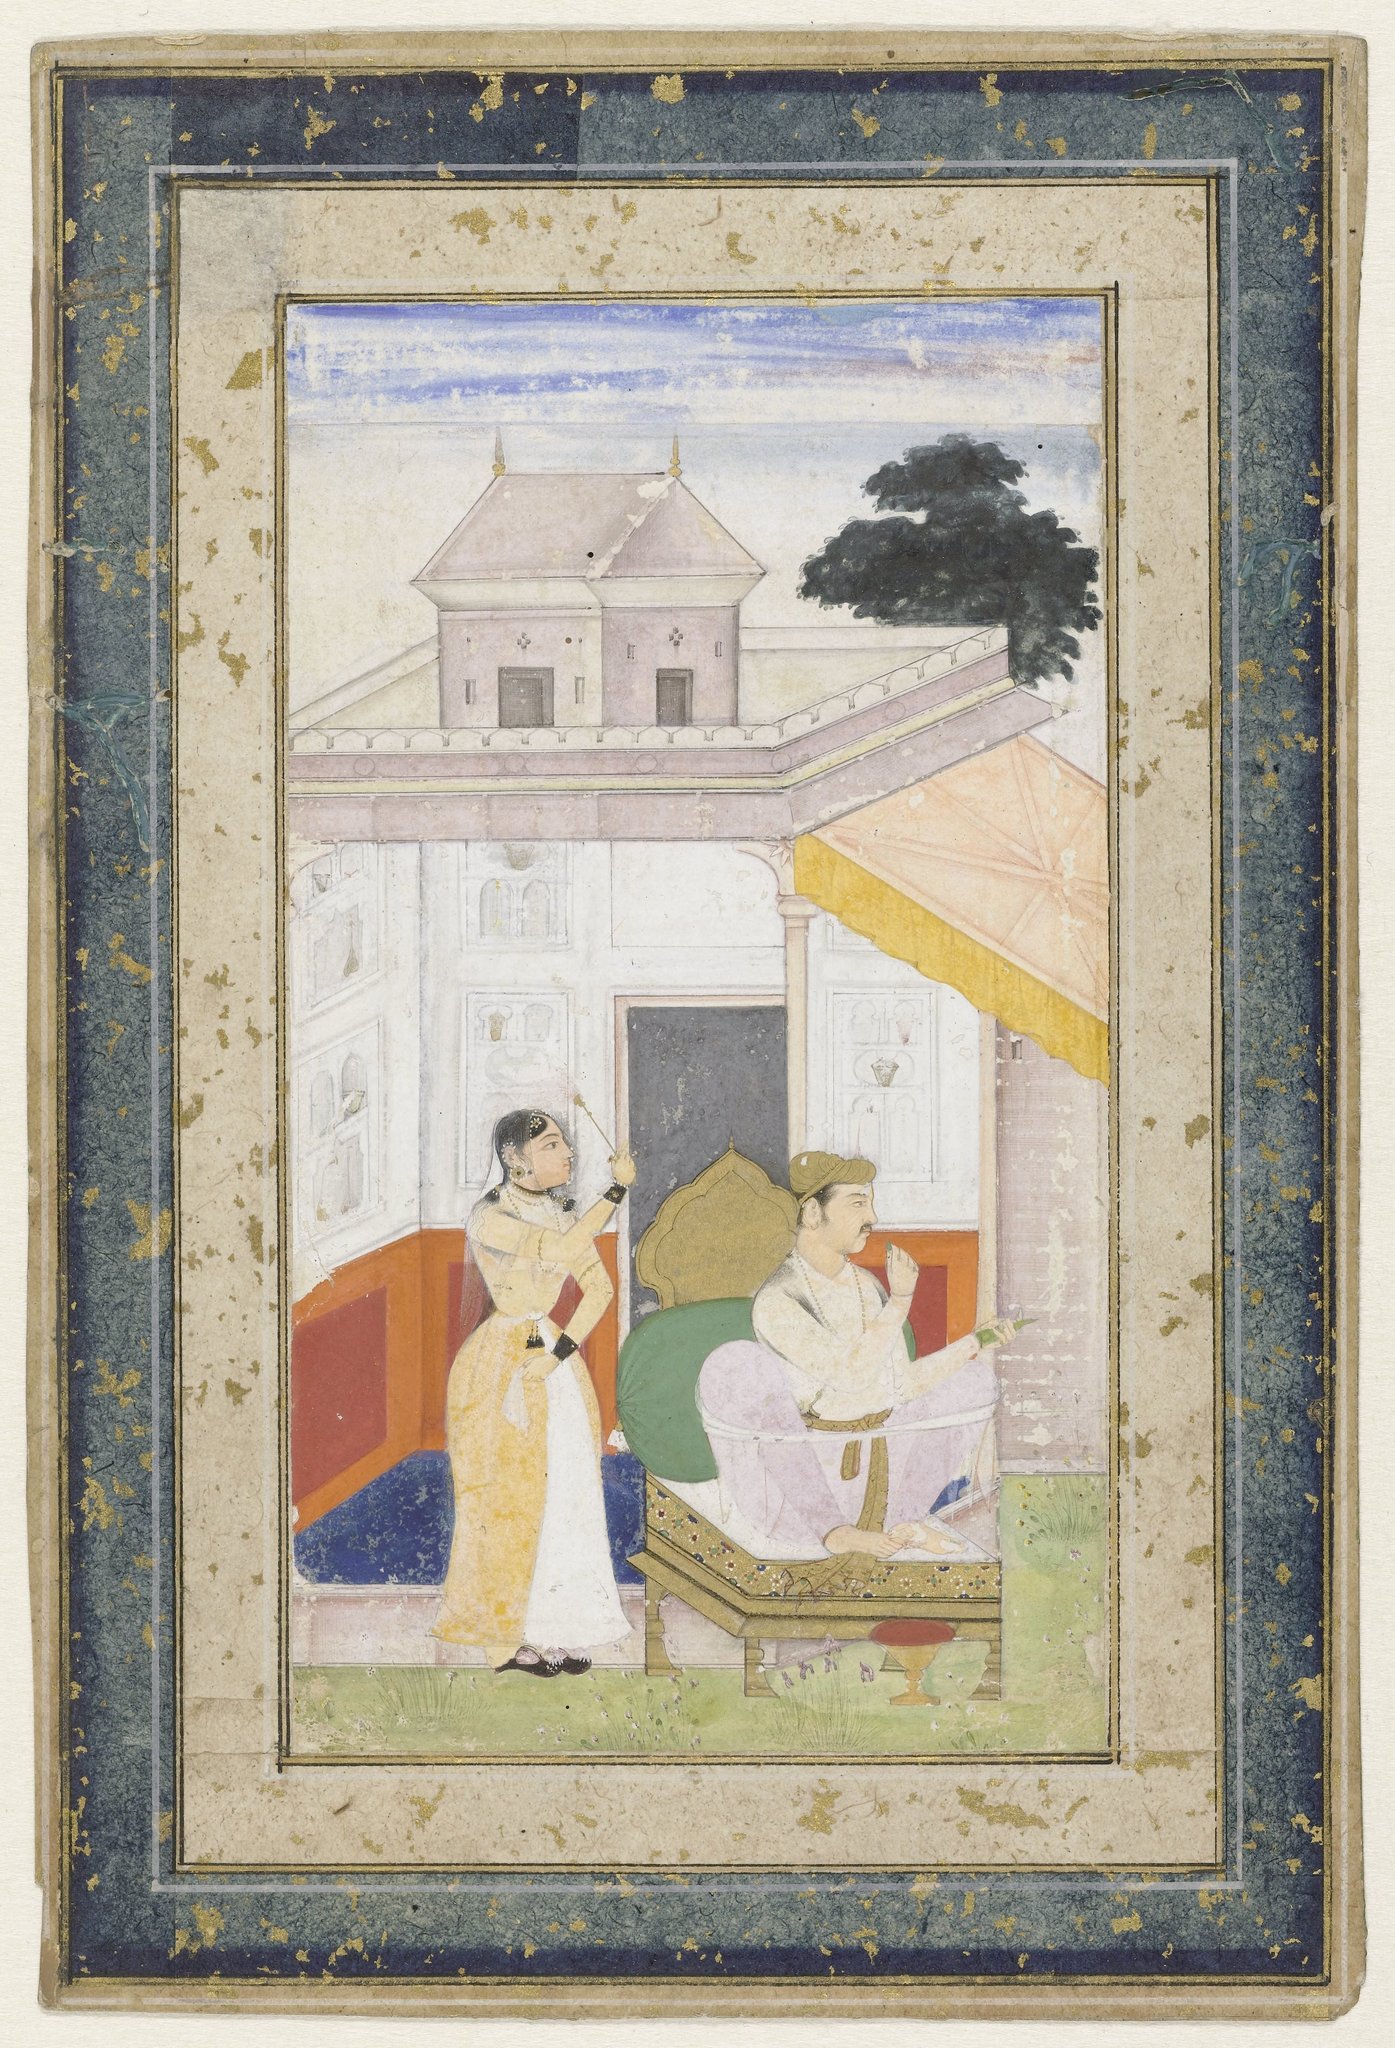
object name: indian miniature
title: Malkos-ragini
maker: Anonymous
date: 1600-1605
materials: gouache, paper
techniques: brush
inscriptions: inscription, signature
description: Op een taboeret zit een prins in een wit gewaad achter hem staat een dienares met een opgeheven stokje. De voorstelling is omlijst door zwarte kaderlijntjes met een biesje goud erin, een dunne sierrand met goudspatsel versierd en een blauwe sierrand met goudspatsel, eveneens met kaderlijntjes, daaromheen nog een smal randje in lichtbruin met een witte kaderlijn.